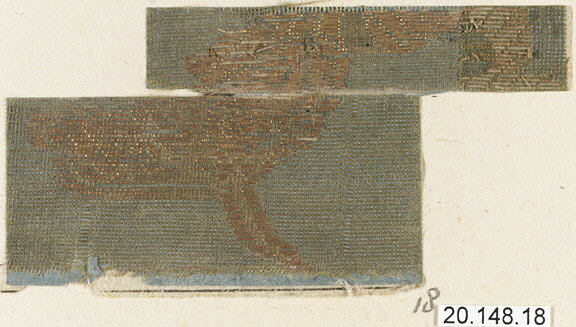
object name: piece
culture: japanese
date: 1101-1200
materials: silk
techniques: compound weave